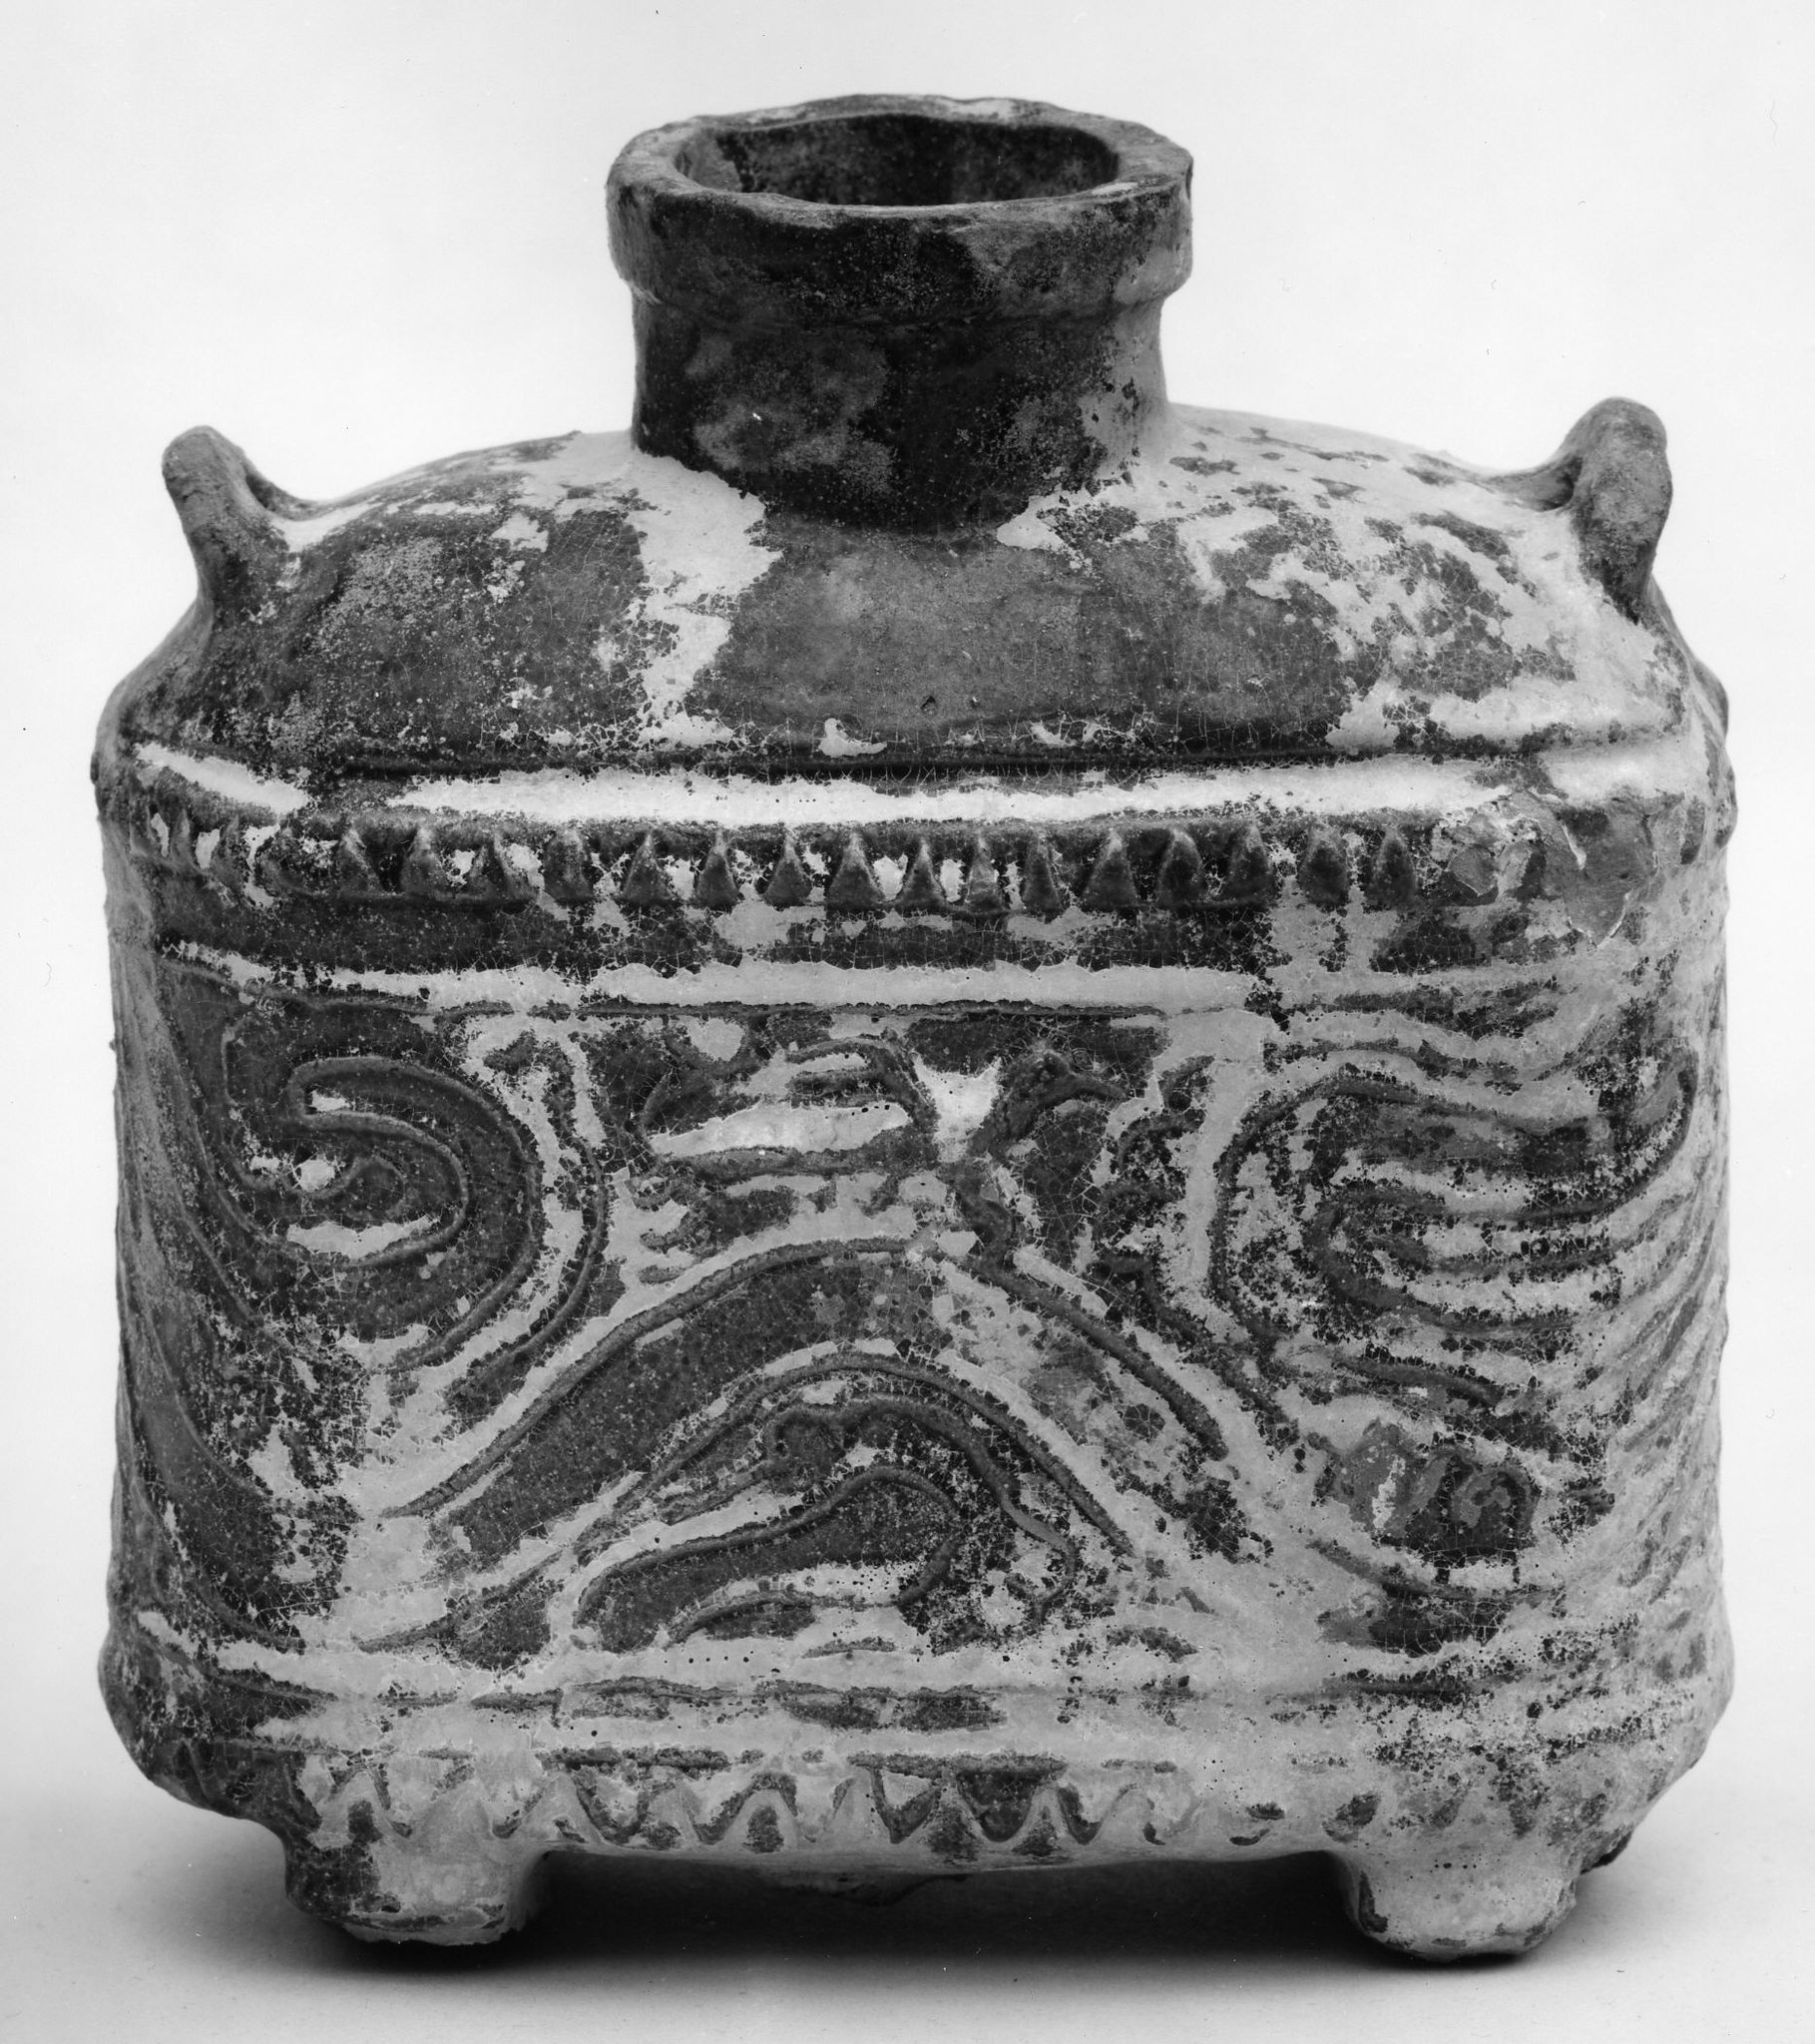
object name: flask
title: Molded Flask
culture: chinese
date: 206 BCE-225 CE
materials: earthenware, glaze